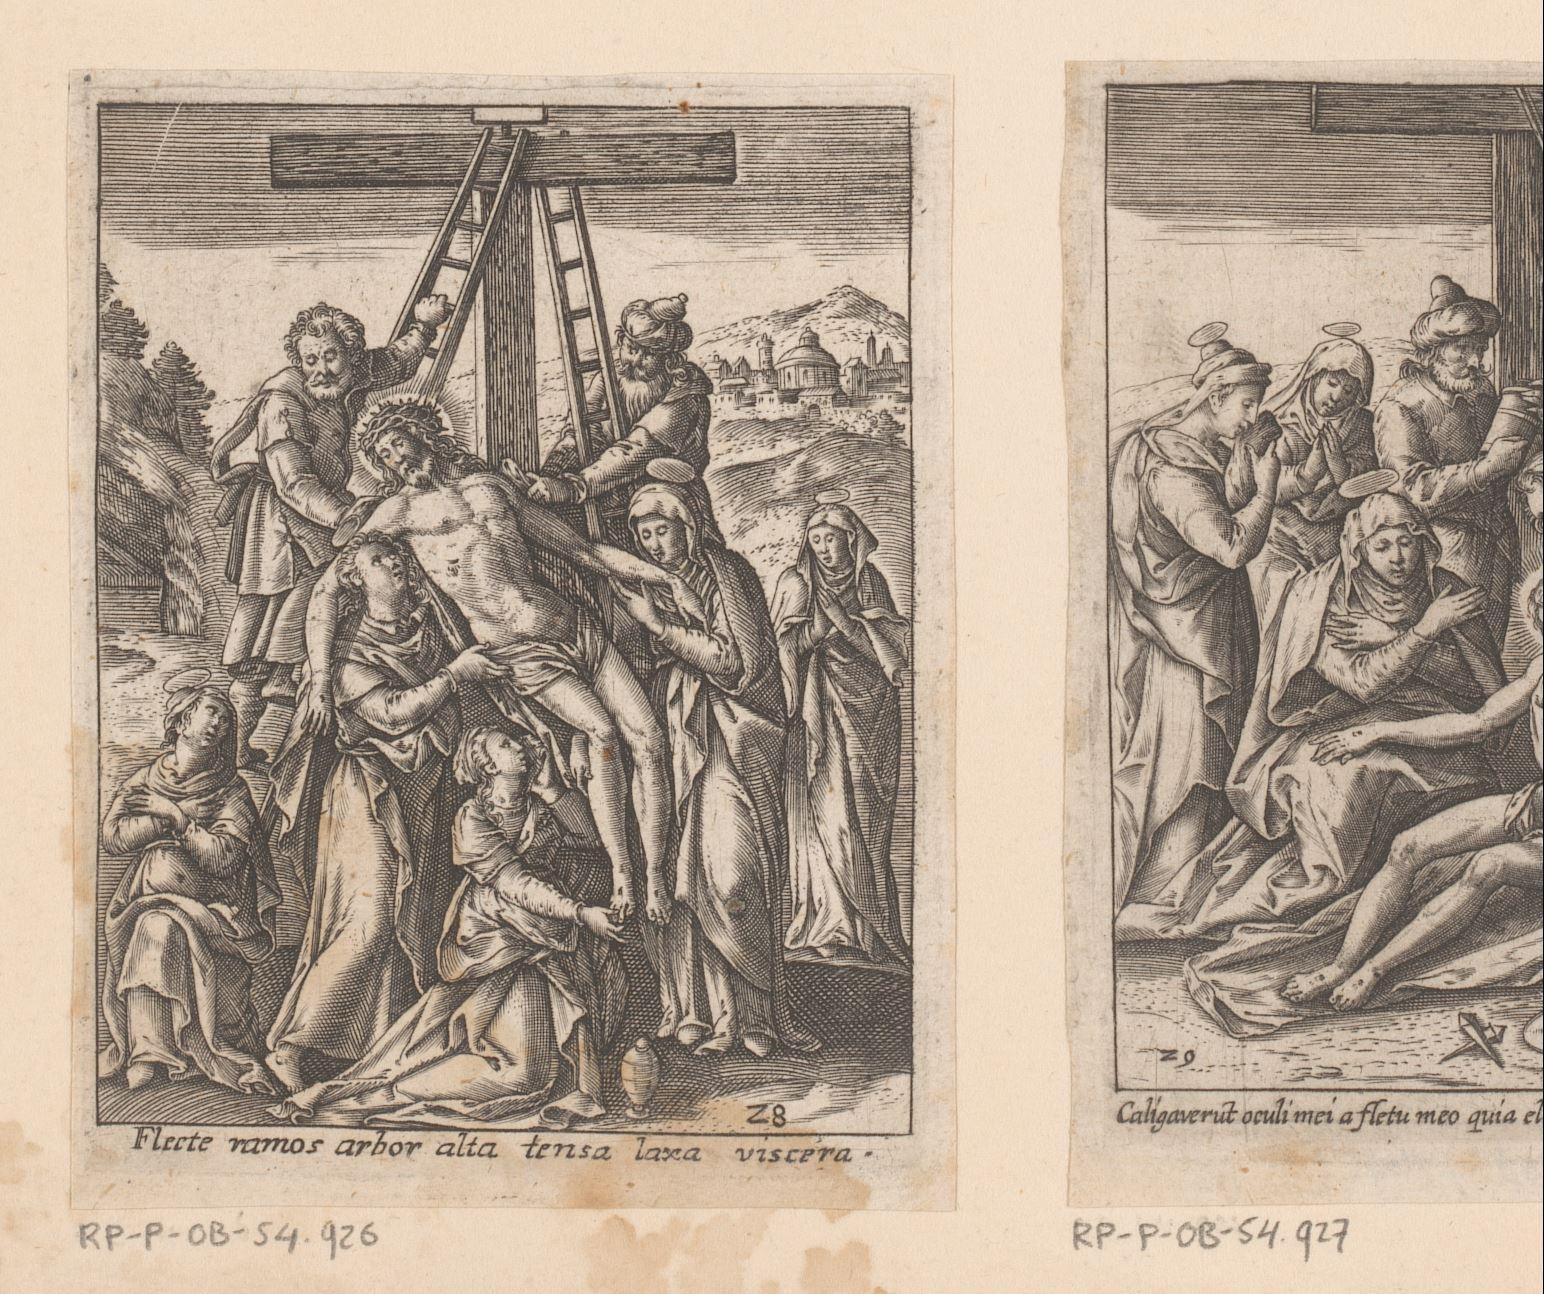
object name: print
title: Leven, passie en wederopstanding van Christus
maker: heinrich ulrich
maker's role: draughtsman, painter, print maker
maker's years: 1572-1671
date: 1582-1671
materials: paper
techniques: engraving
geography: germany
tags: descent from the cross: christ is taken down from the cross, usually by nicodemus and joseph of arimathaea who are standing on the ladders (both arms of christ detached)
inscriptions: collector's mark: Lugt 240, number: ‘38. - 64.’